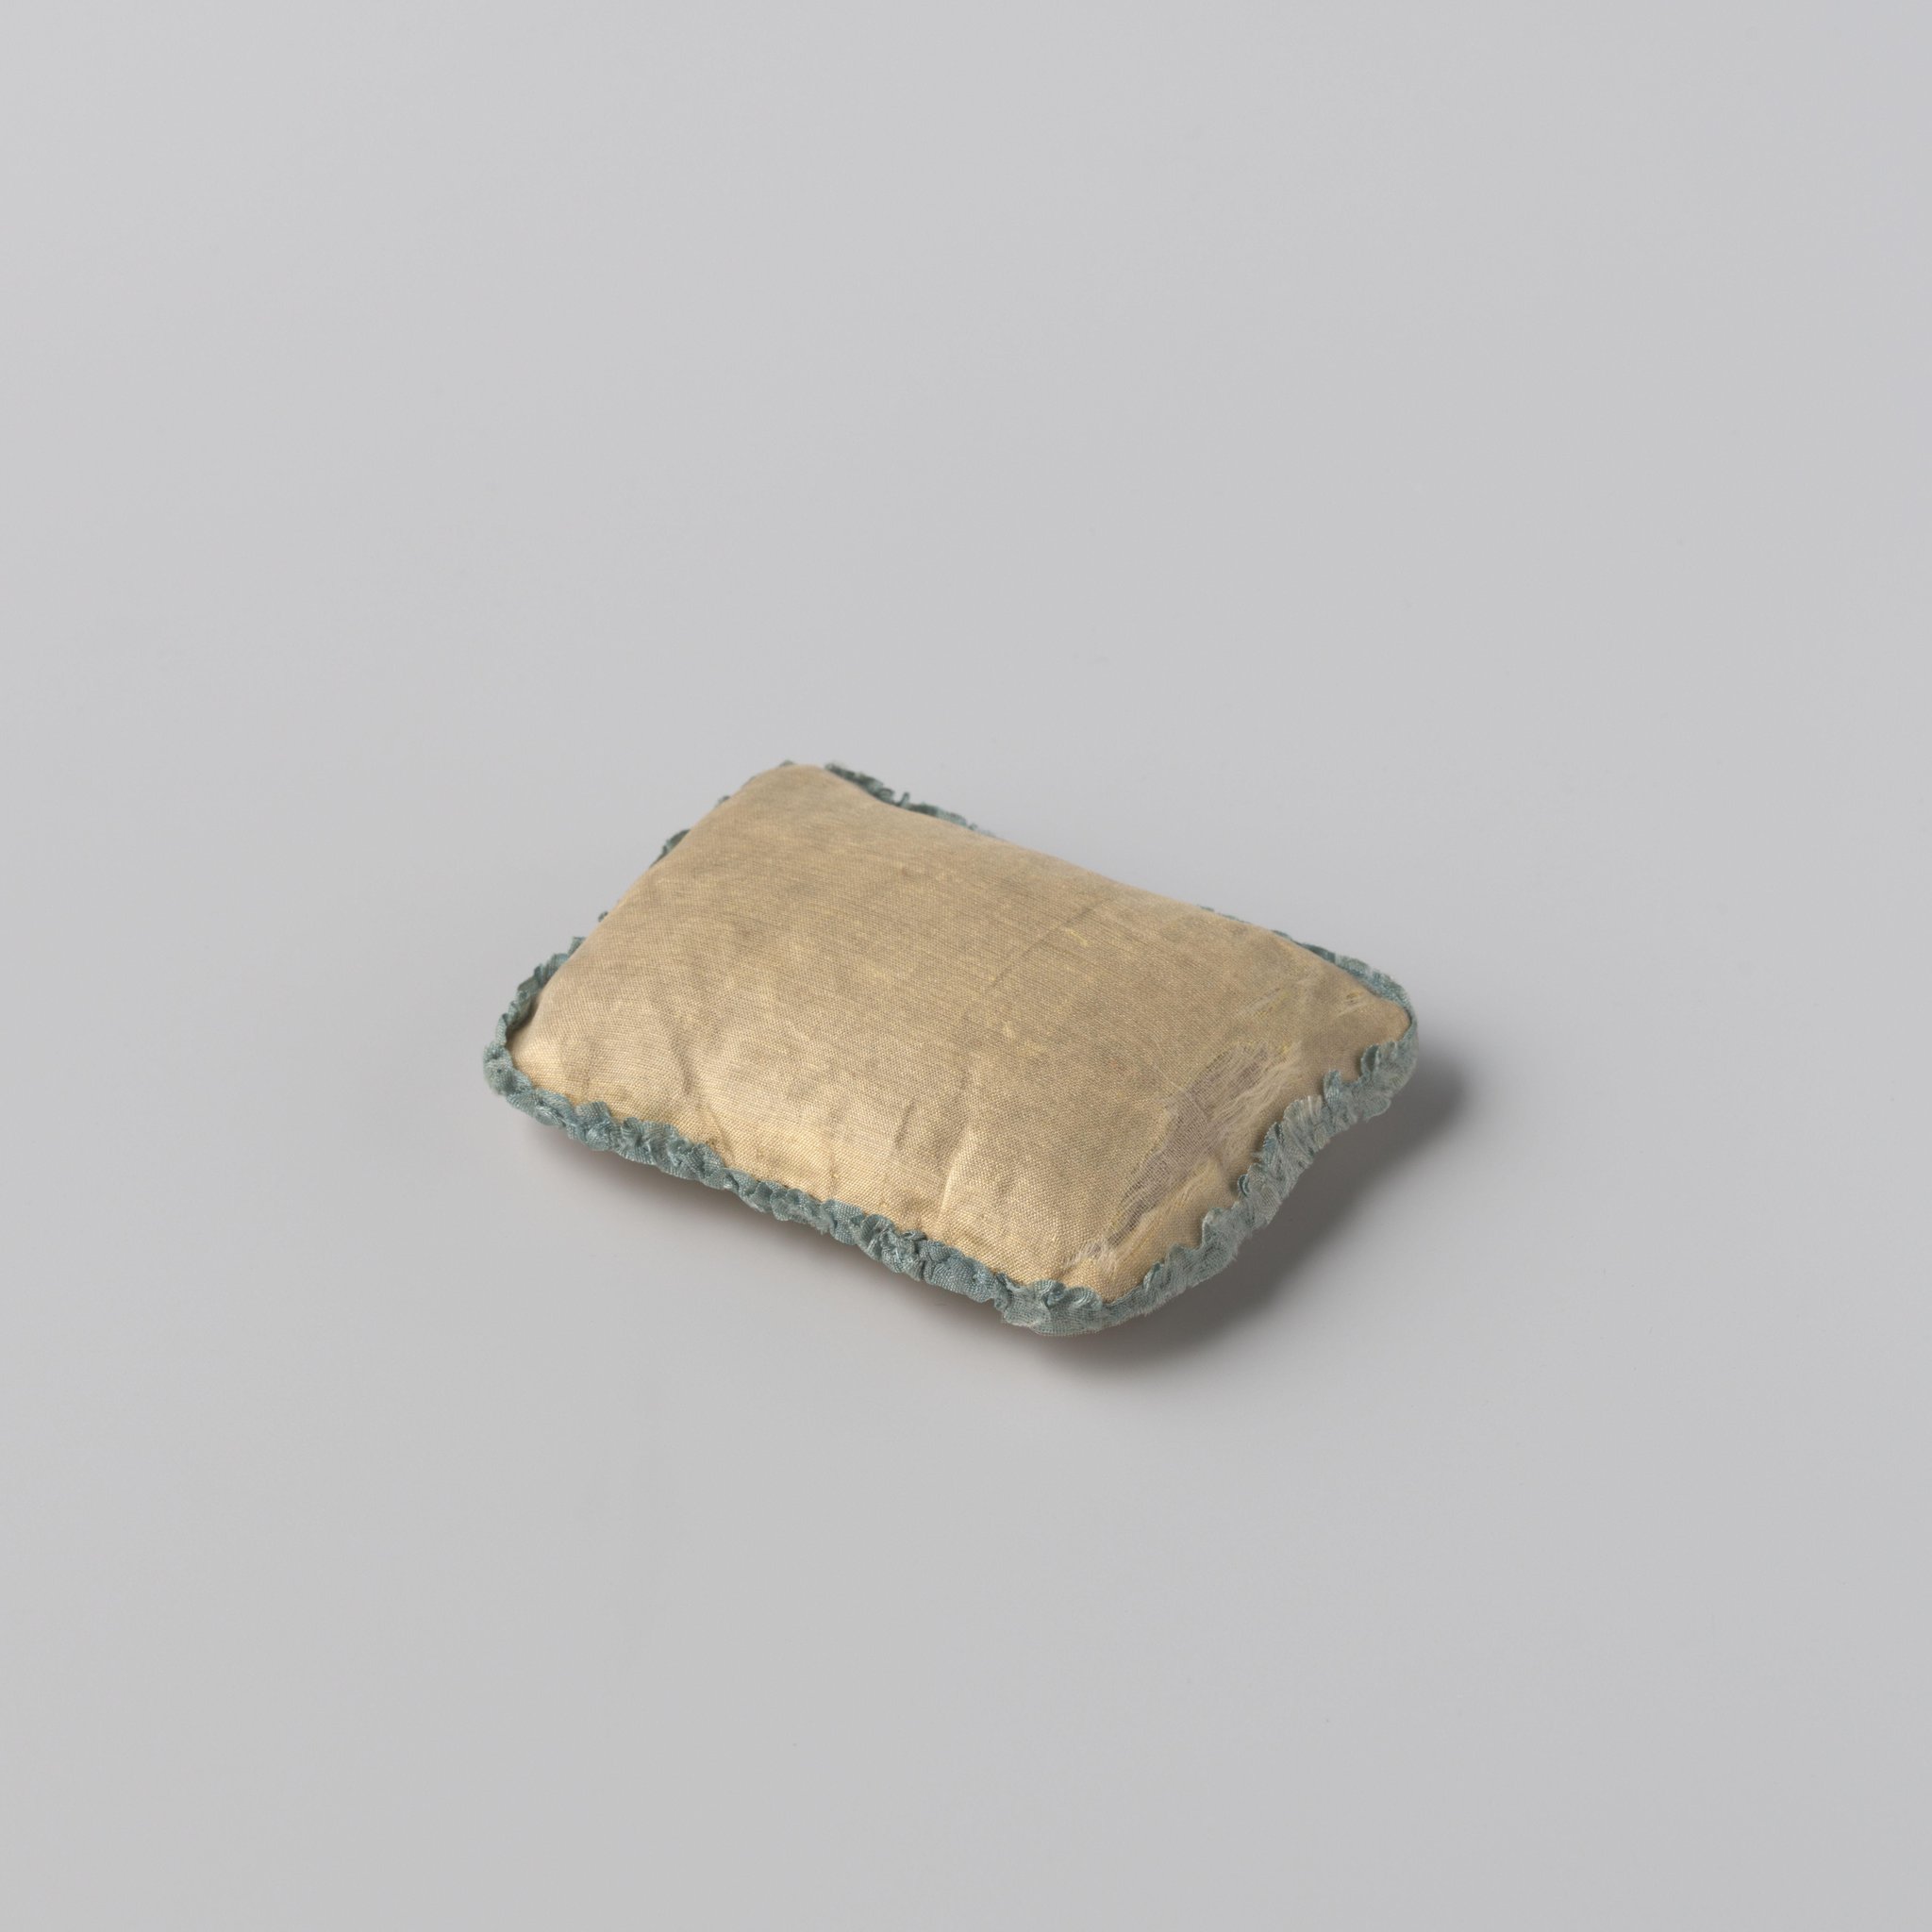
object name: cushion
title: Rechthoekig kussen vervaardigd van licht gele zijde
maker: Anonymous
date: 1690-1710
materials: down, silk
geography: amsterdam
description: Rechthoekige kussen vervaardigd van licht gele zijde, rondom afgezet met een ingerimpeld lintje van licht blauwe zijde. De kussens zijn gevuld met dons oorspronkelijk zonder tussenvoering.